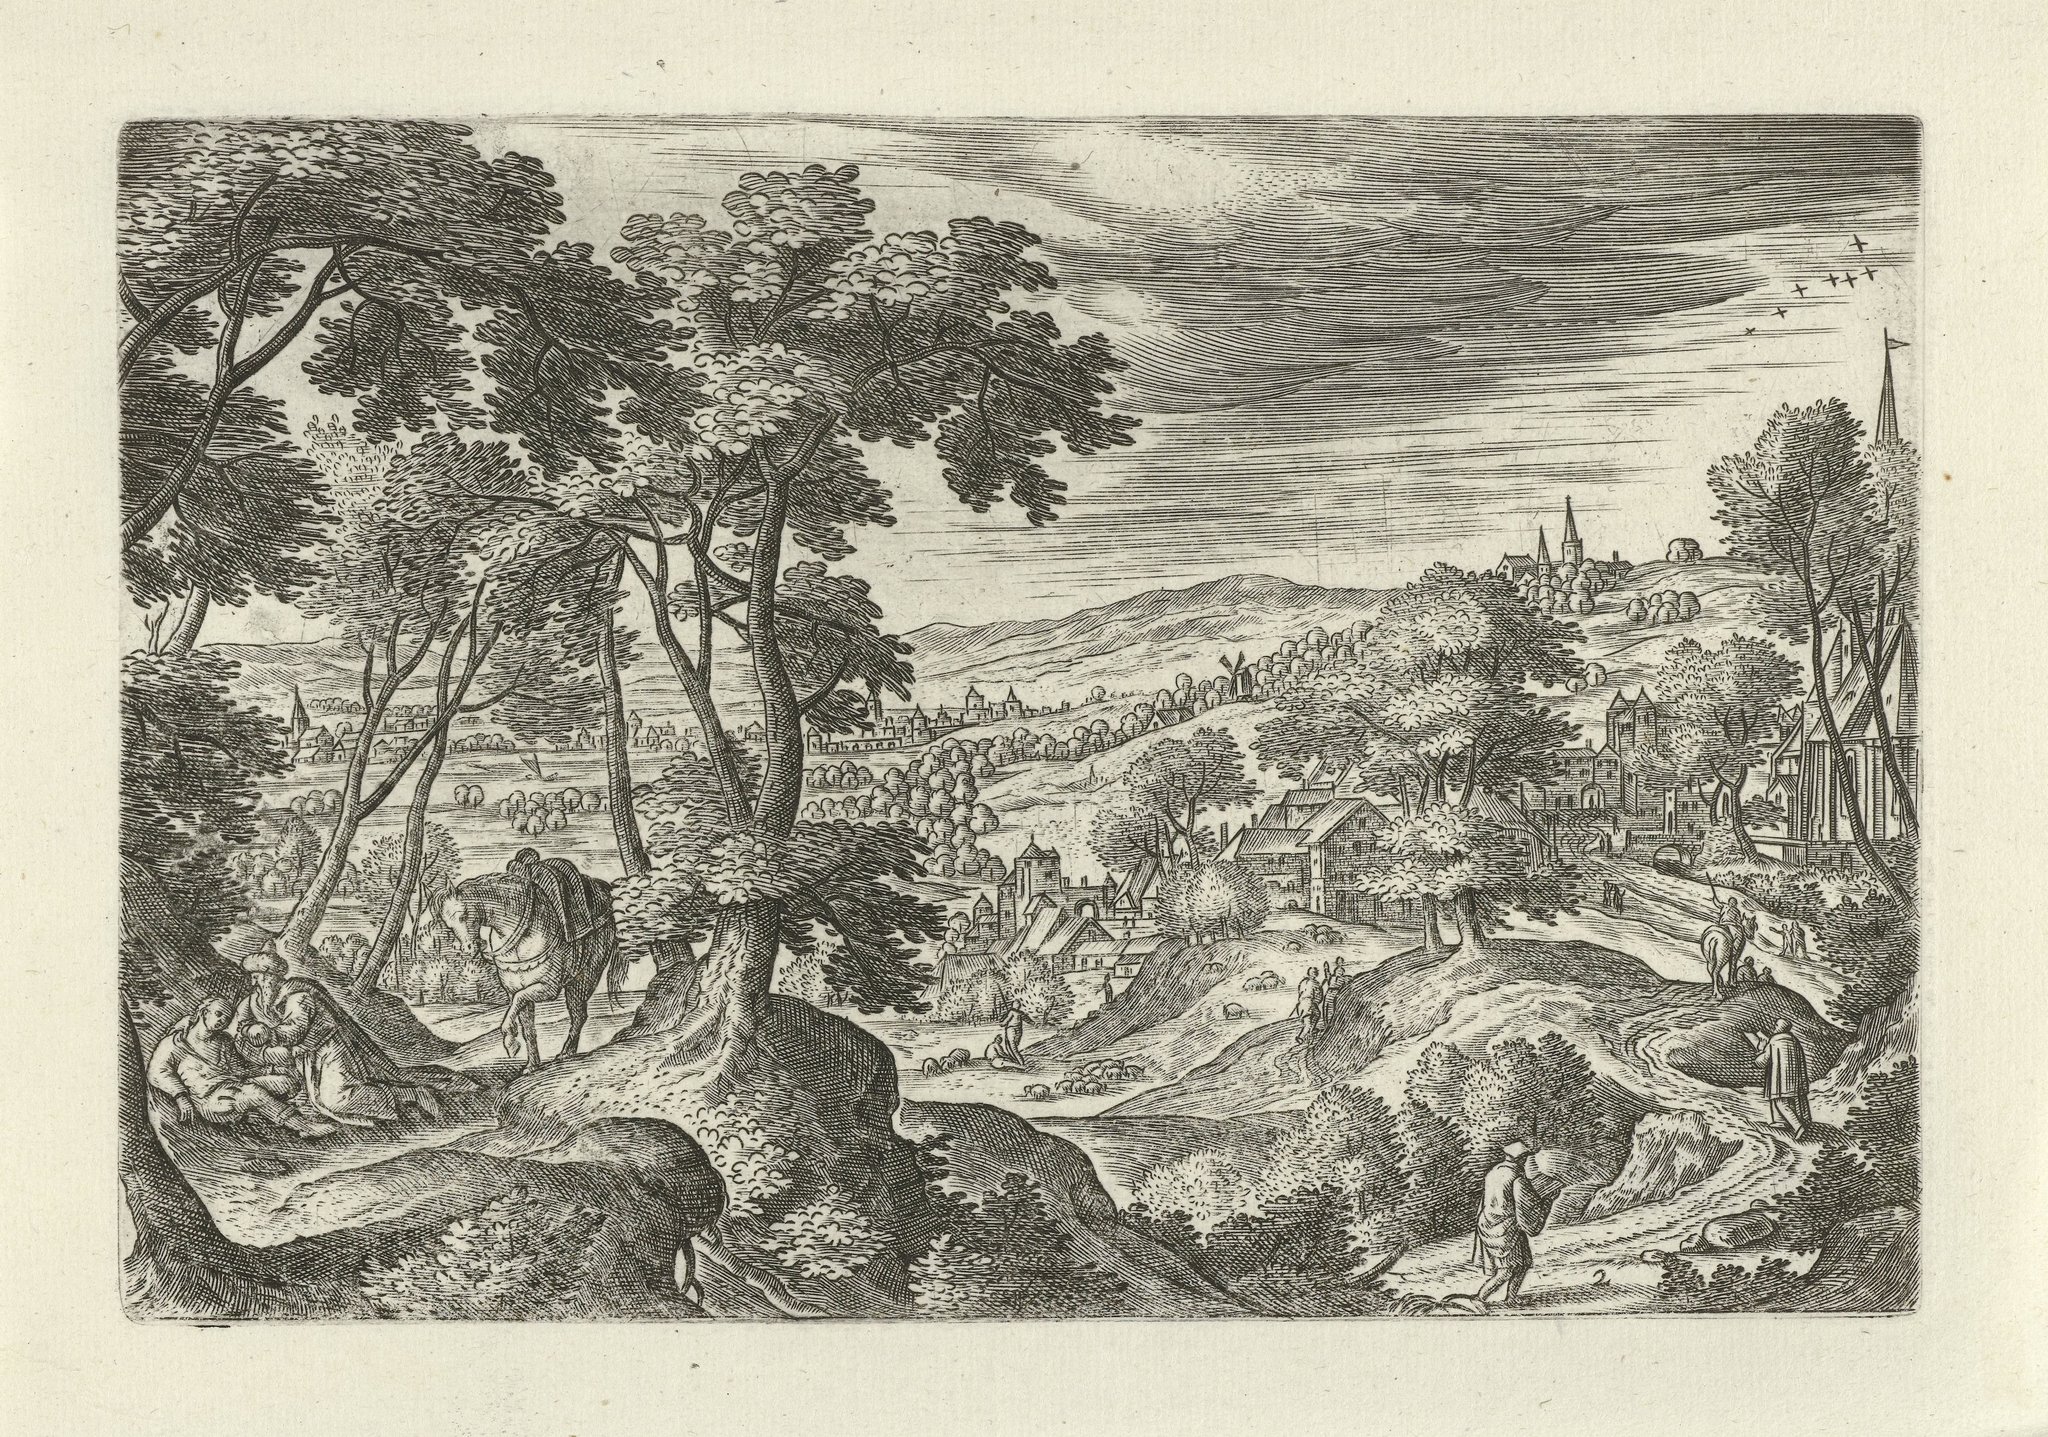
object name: print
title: Landschap met de reiziger die door de barmhartige Samaritaan wordt verzorgd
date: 1560-1595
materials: paper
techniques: engraving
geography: antwerp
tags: a samaritan tending the wounds of the traveller, forest, wood (+ landscape with figures, staffage), outskirts of village (+ city(-scape) with figures, staffage)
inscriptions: collector's mark: Lugt 2228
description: De barmhartige Samaritaan vindt de reiziger en verpleegt zijn wonden. Op de achtergrond de priester en de leviet. De prent is deel van een vierdelige serie van landschappen met scènes uit de gelijkenis van de barmhartige Samaritaan